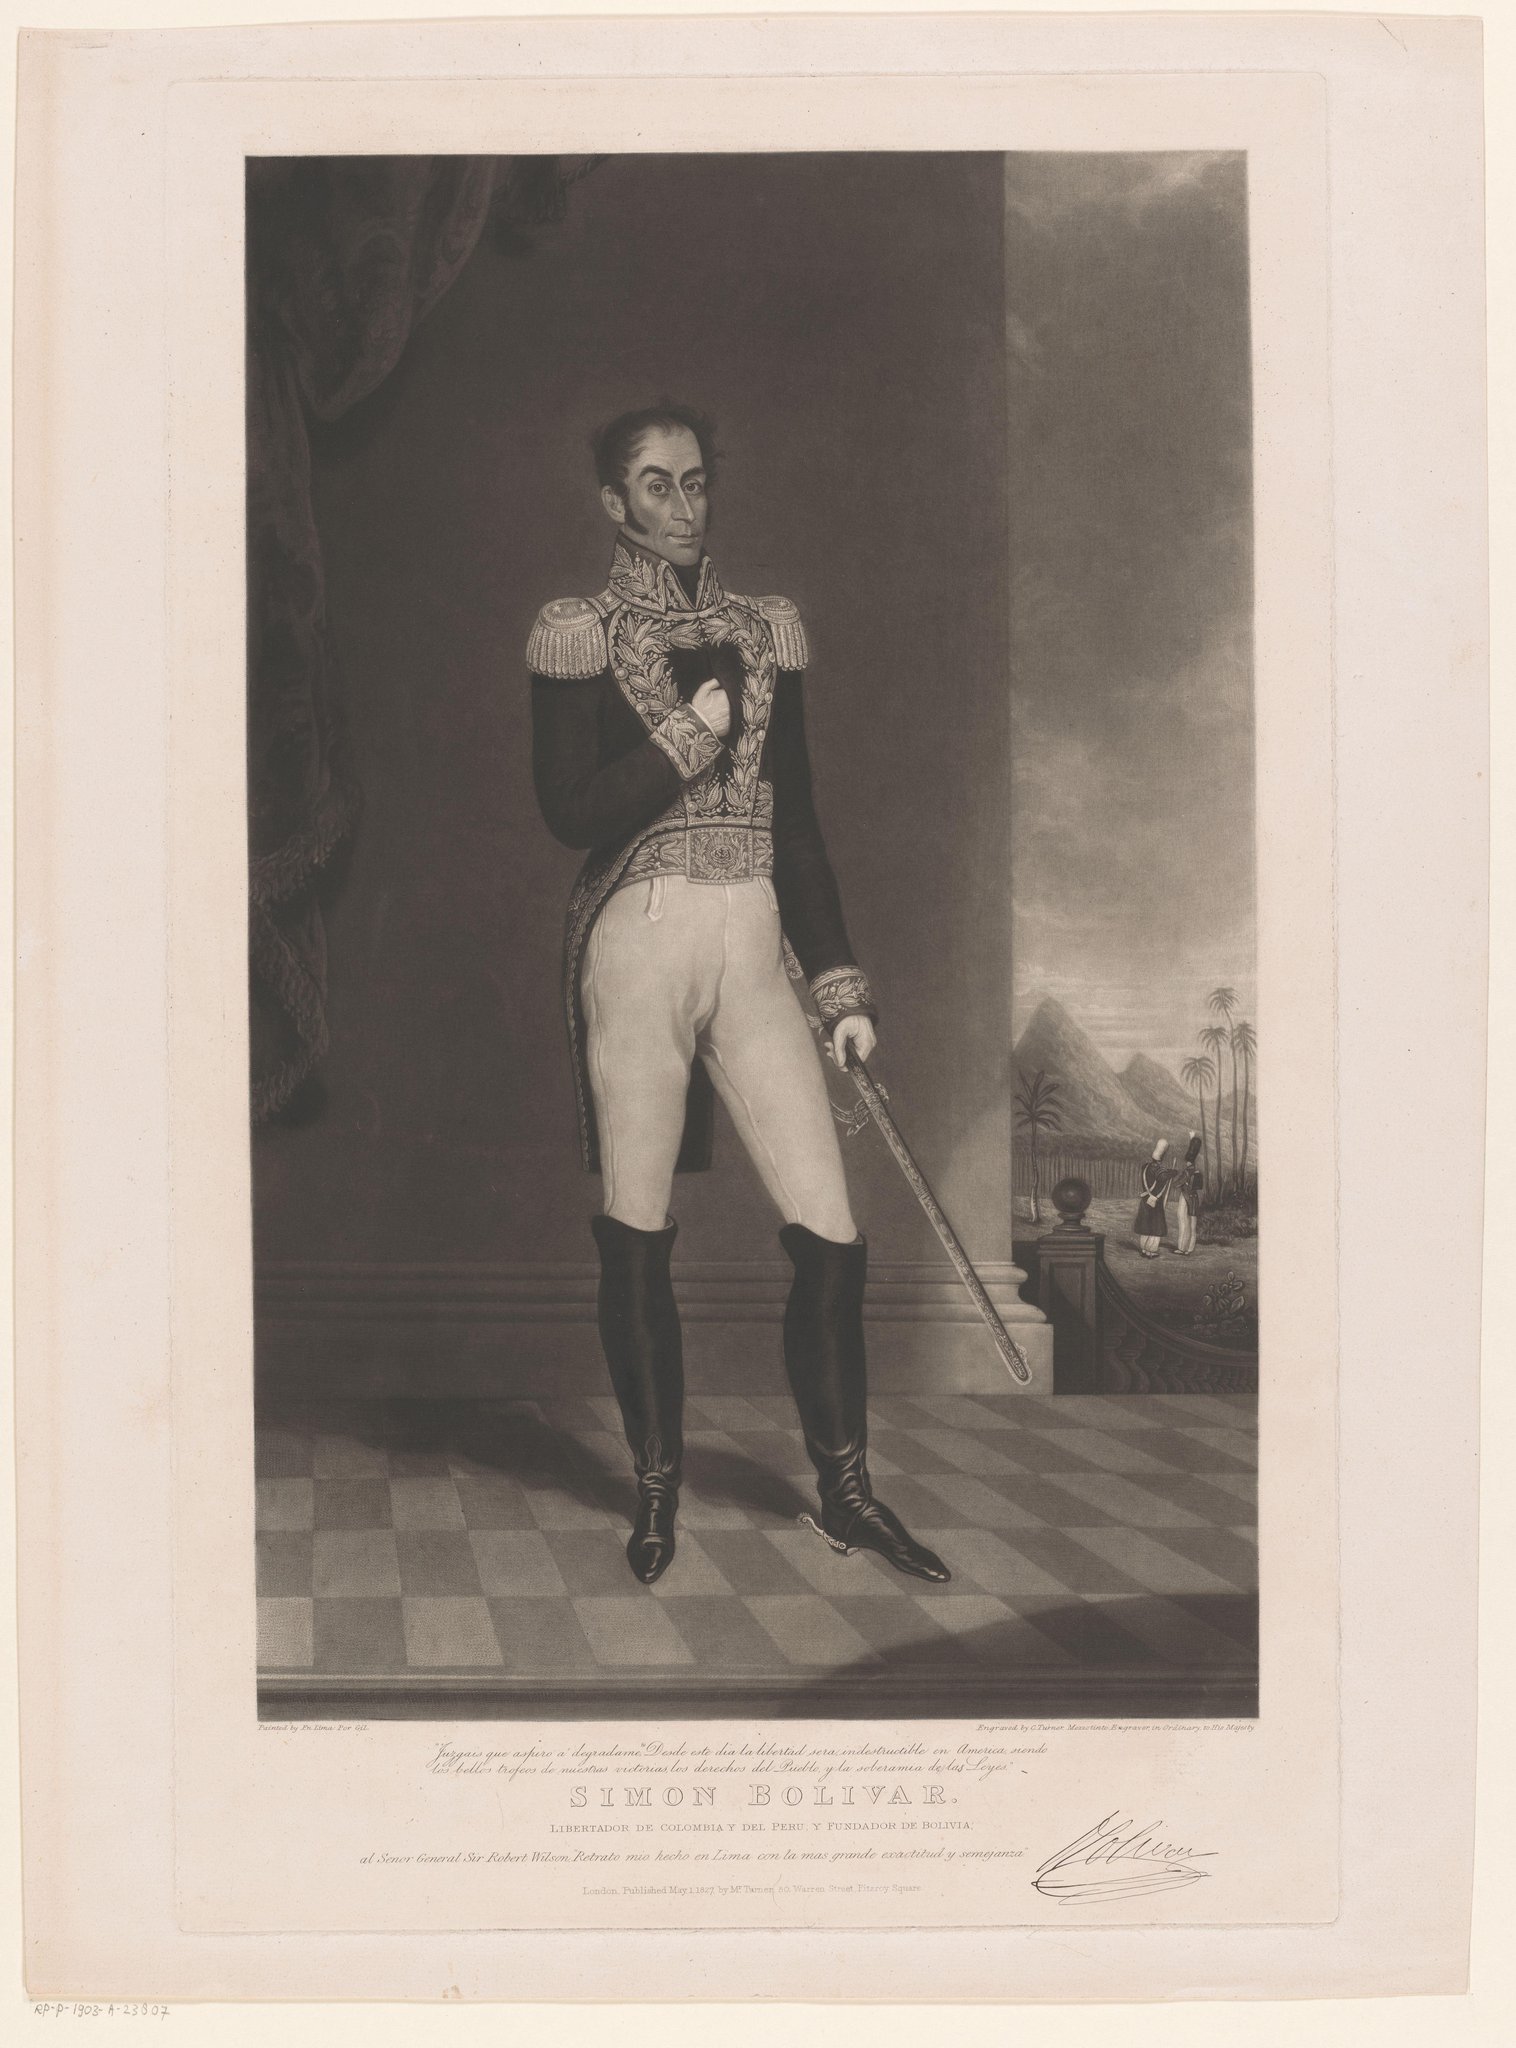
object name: print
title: Portret van Simón Bolívar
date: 1827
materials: paper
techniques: etching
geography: lima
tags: politician, historical persons, politician, e.g. party leader, officer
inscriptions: collector's mark: Lugt 2228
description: Tekst in het Spaans in de ondermarge. Een facsimile signatuur in de ondermarge.